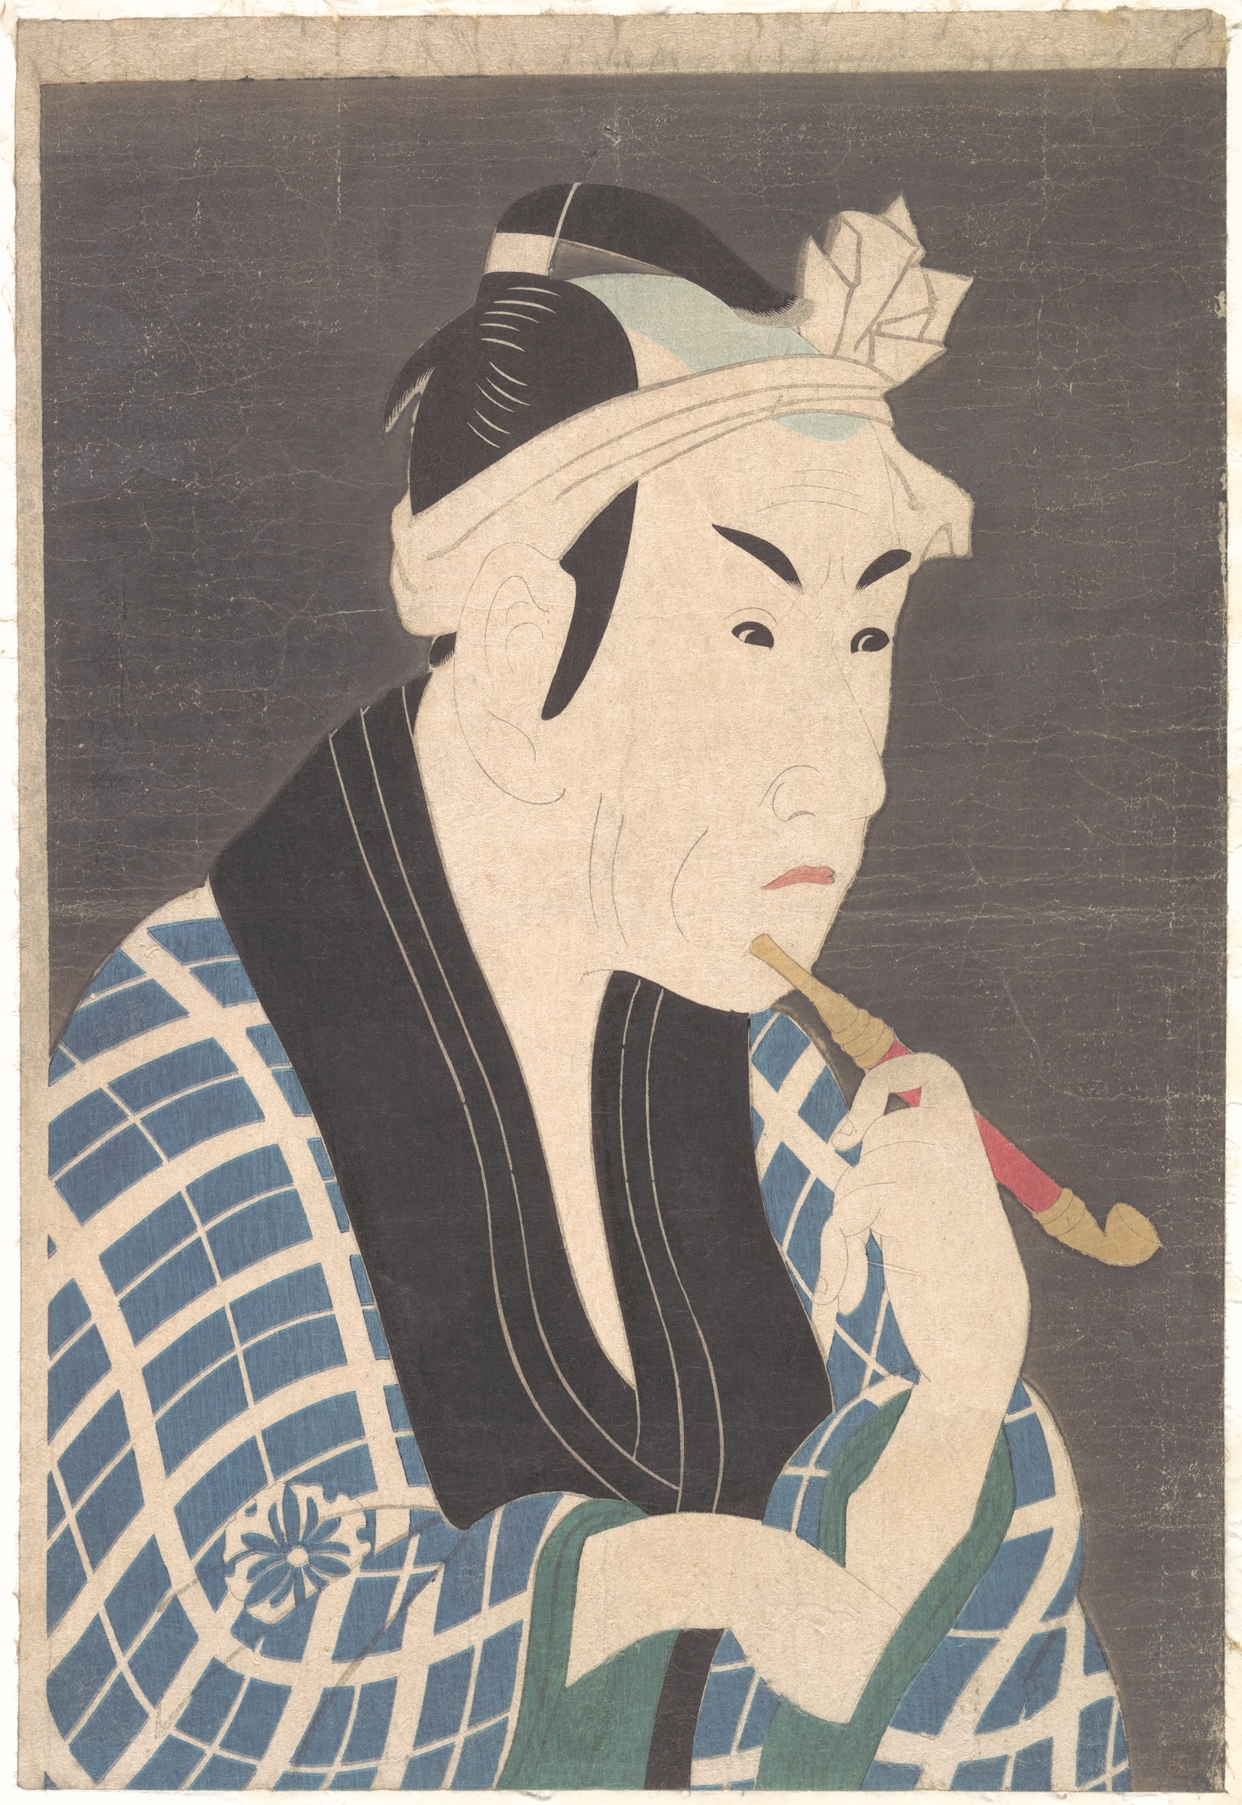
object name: woodblock print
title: Matsumoto Koshiro IV as the Fish Peddler Gorobei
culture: japanese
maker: tōshūsai sharaku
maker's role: artist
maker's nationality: japanese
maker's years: 1794-1795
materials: ink, mica, paper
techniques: woodblock print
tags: men,actors,pipes